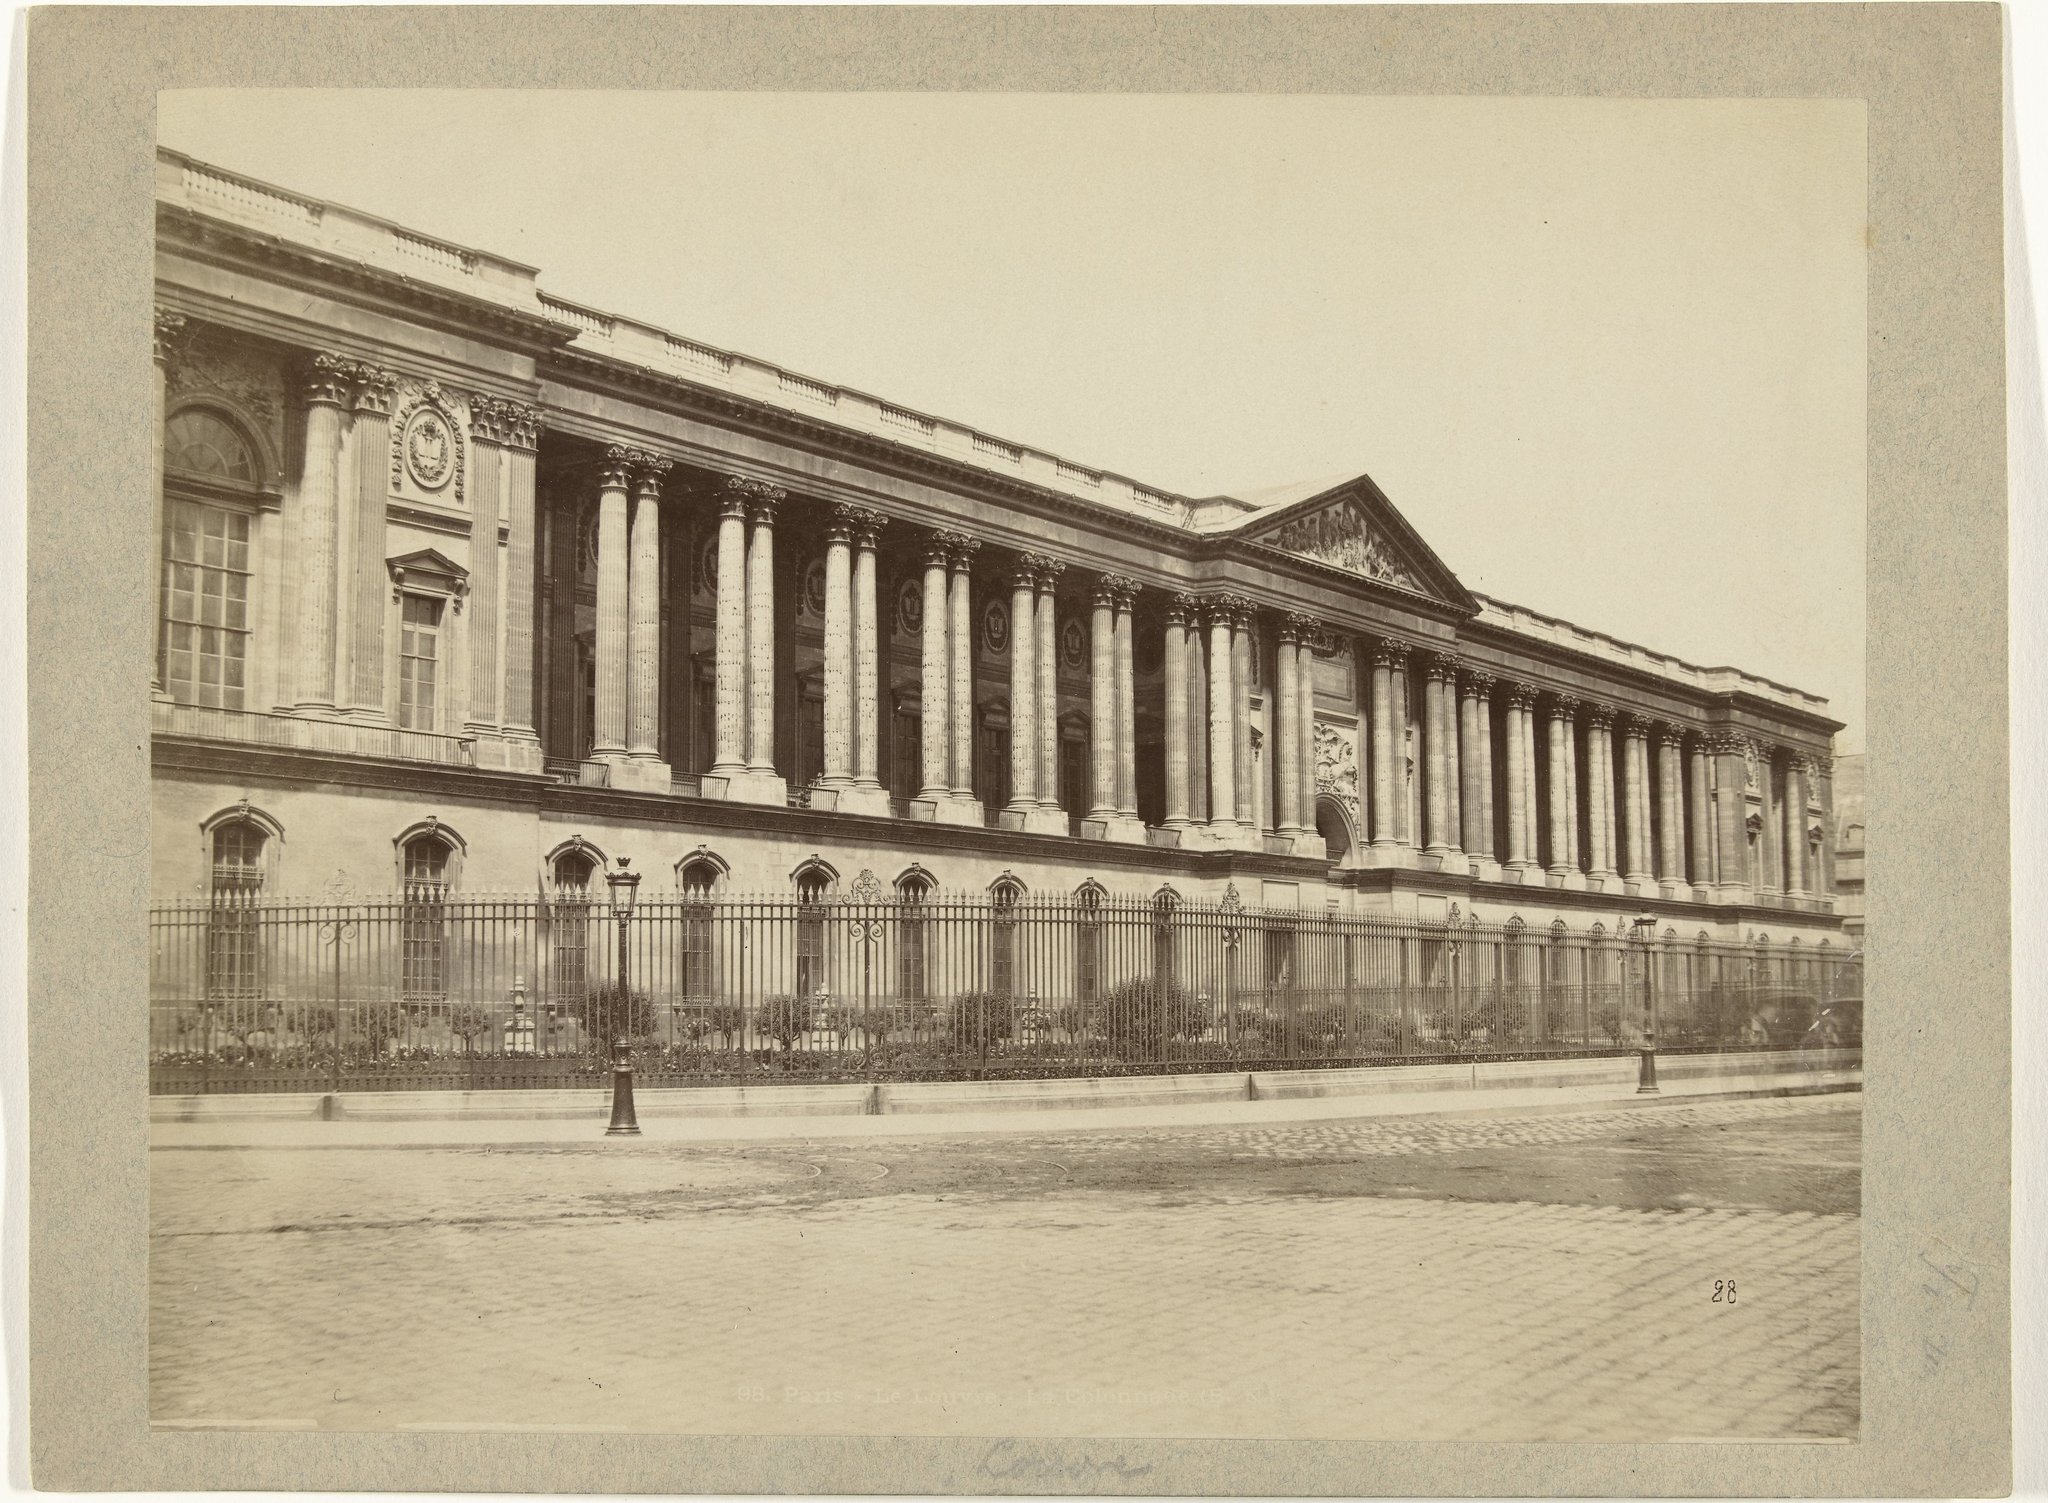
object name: photograph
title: Gezicht op het Louvre in Parijs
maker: Anonymous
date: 1860-1890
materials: cardboard, paper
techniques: albumen print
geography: paris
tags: permanent exhibition, museum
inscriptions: number: ‘98.’, number: ‘28’, collector's mark: Lugt 3937